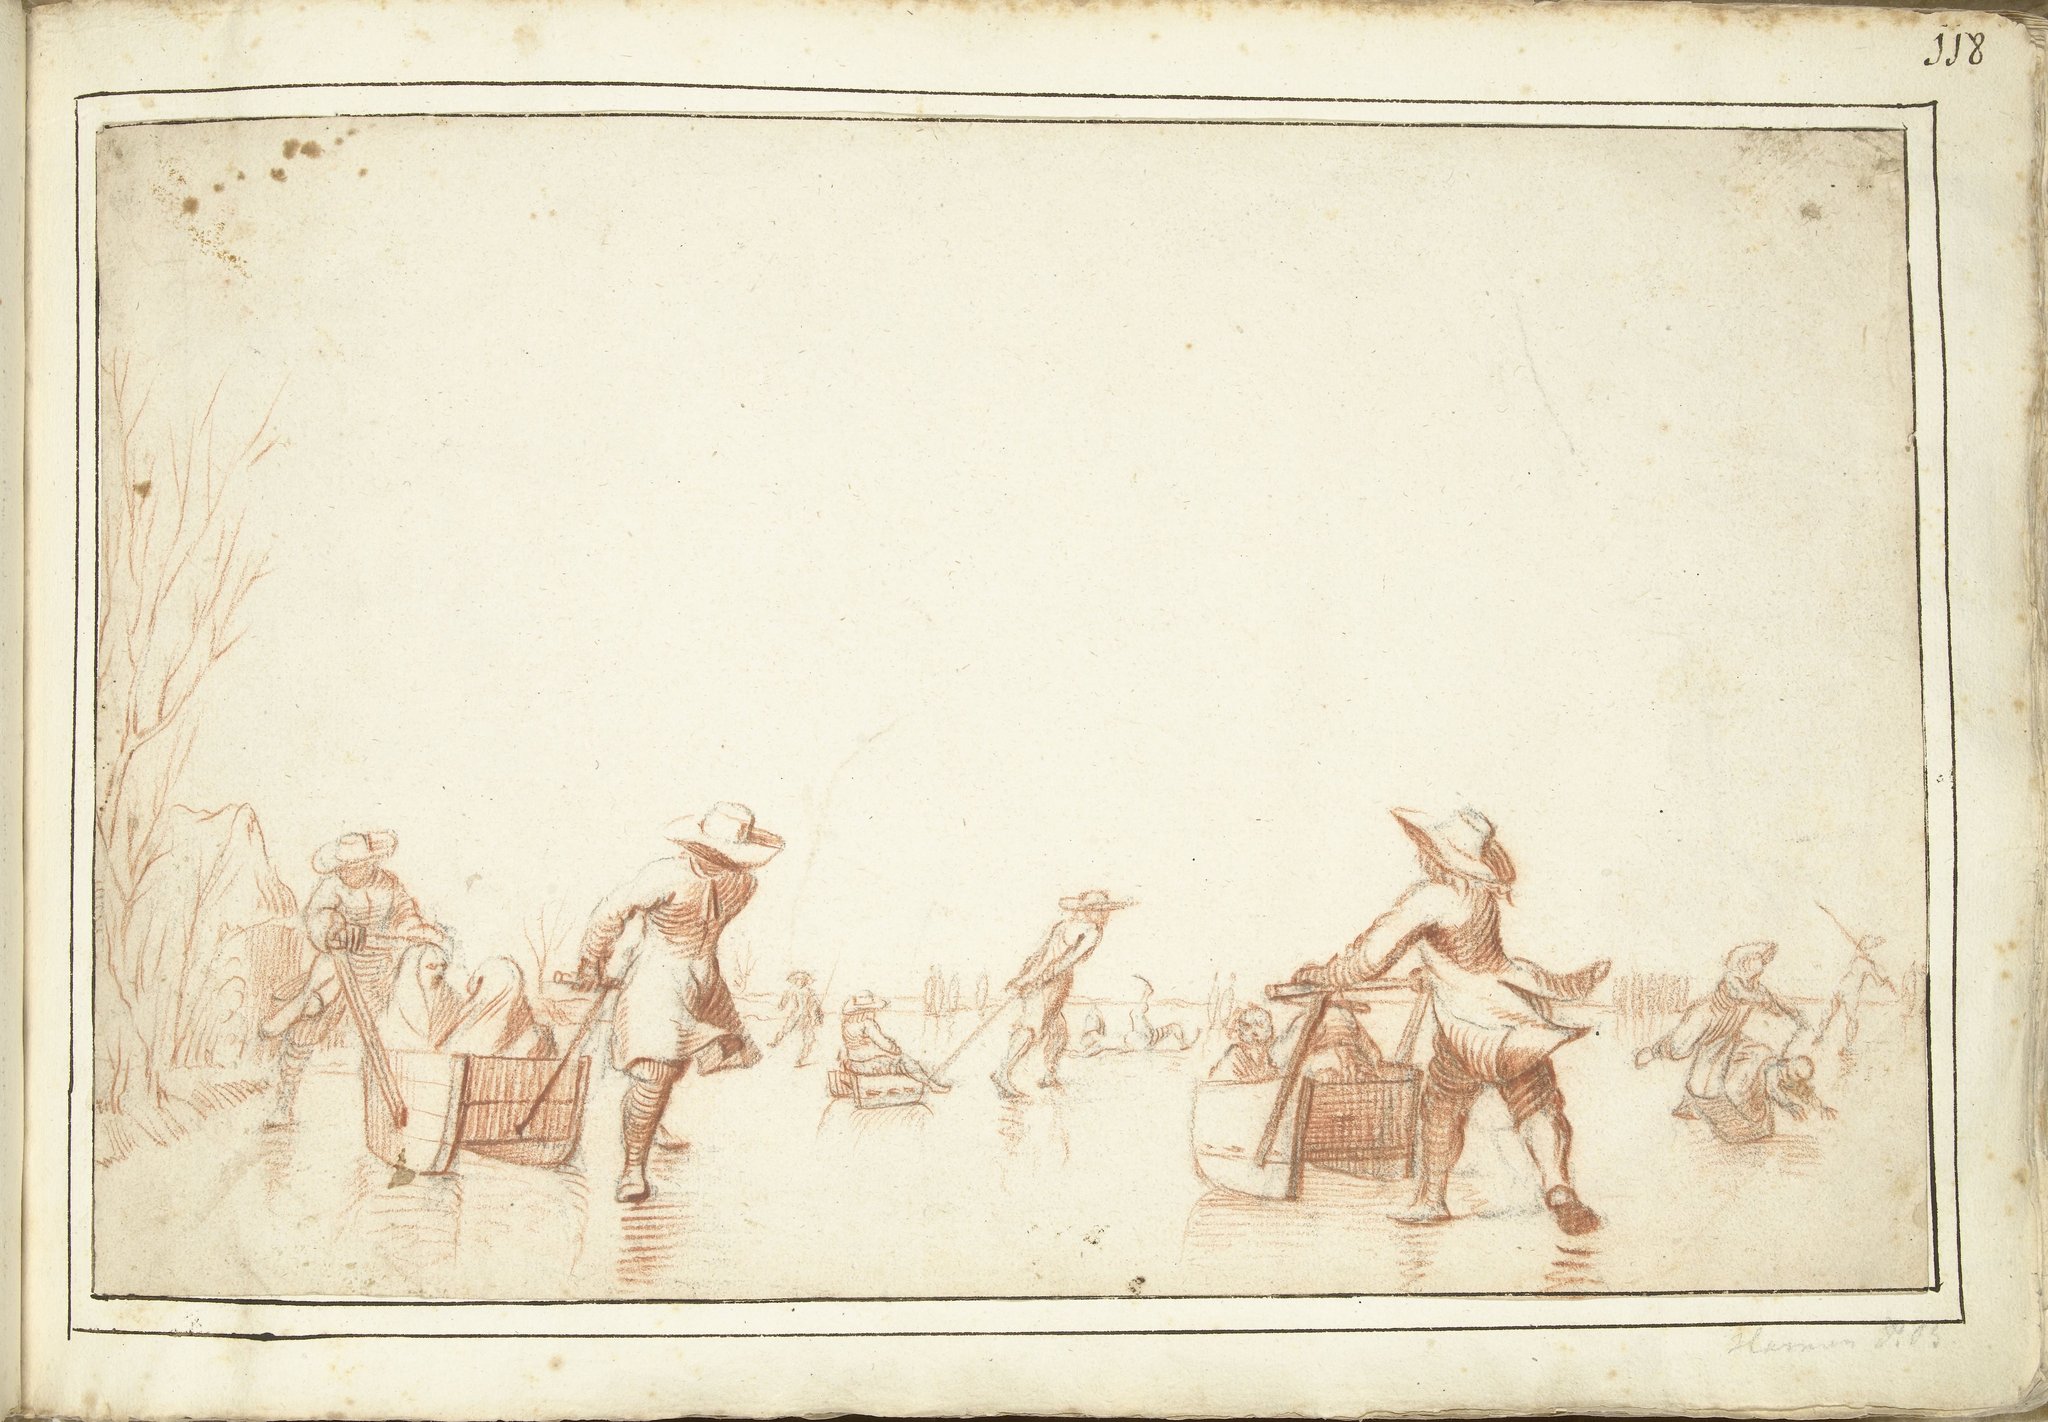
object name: drawing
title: Winterscène op het ijs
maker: harmen ter borch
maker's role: draughtsman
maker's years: 1638-1677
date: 1648-1677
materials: chalk, paper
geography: zwolle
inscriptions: address: ‘Harmen T.B’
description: De tekening is opgeplakt in het Familie-plakboek.